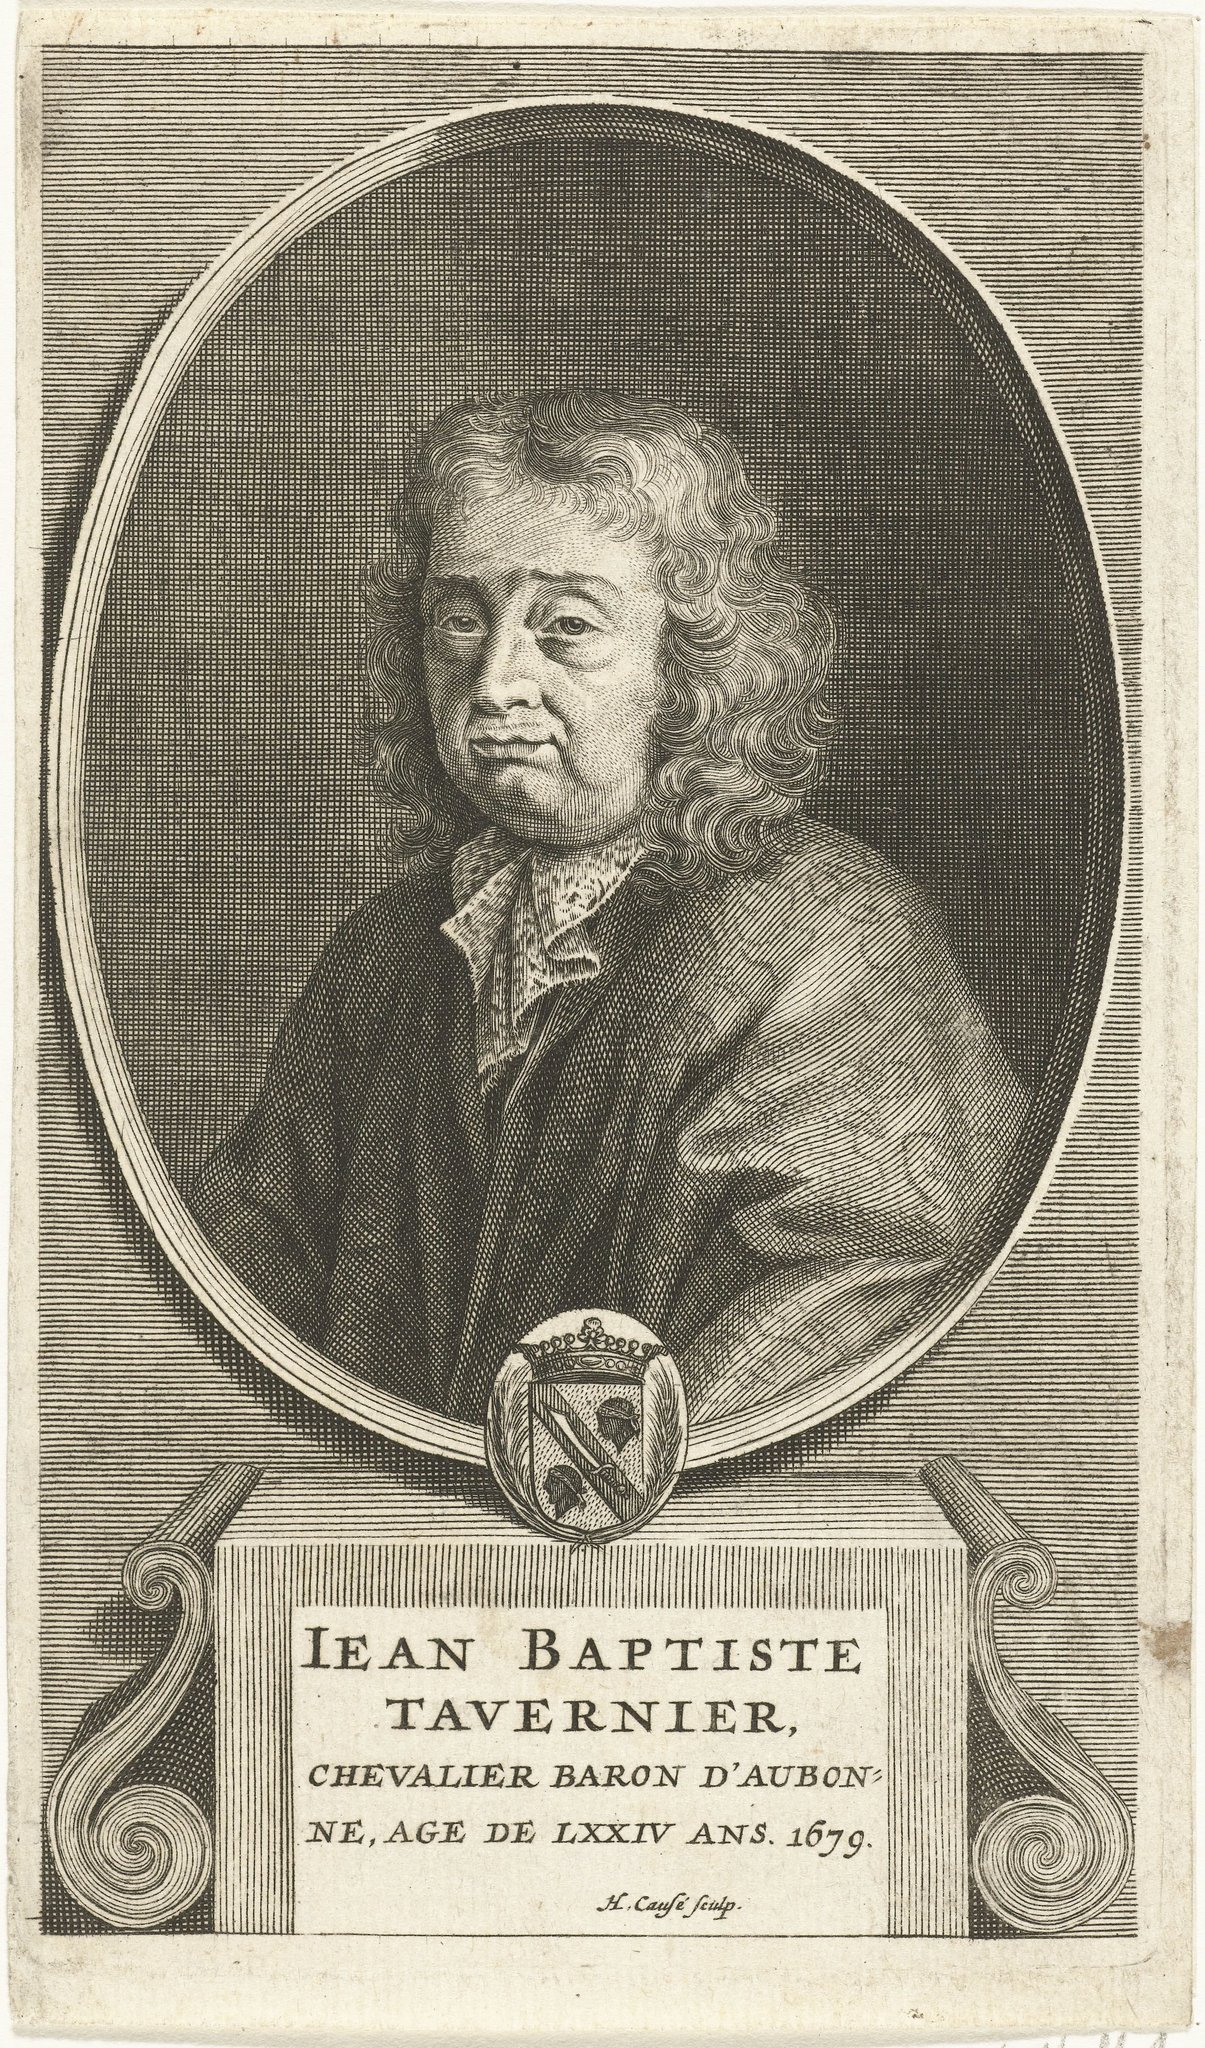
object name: print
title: Portret van Jean Baptiste Tavernier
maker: hendrik causé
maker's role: print maker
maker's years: 1648-1699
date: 1679-1699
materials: paper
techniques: engraving, etching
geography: antwerp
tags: paris, traveler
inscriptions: collector's mark: Lugt 2228